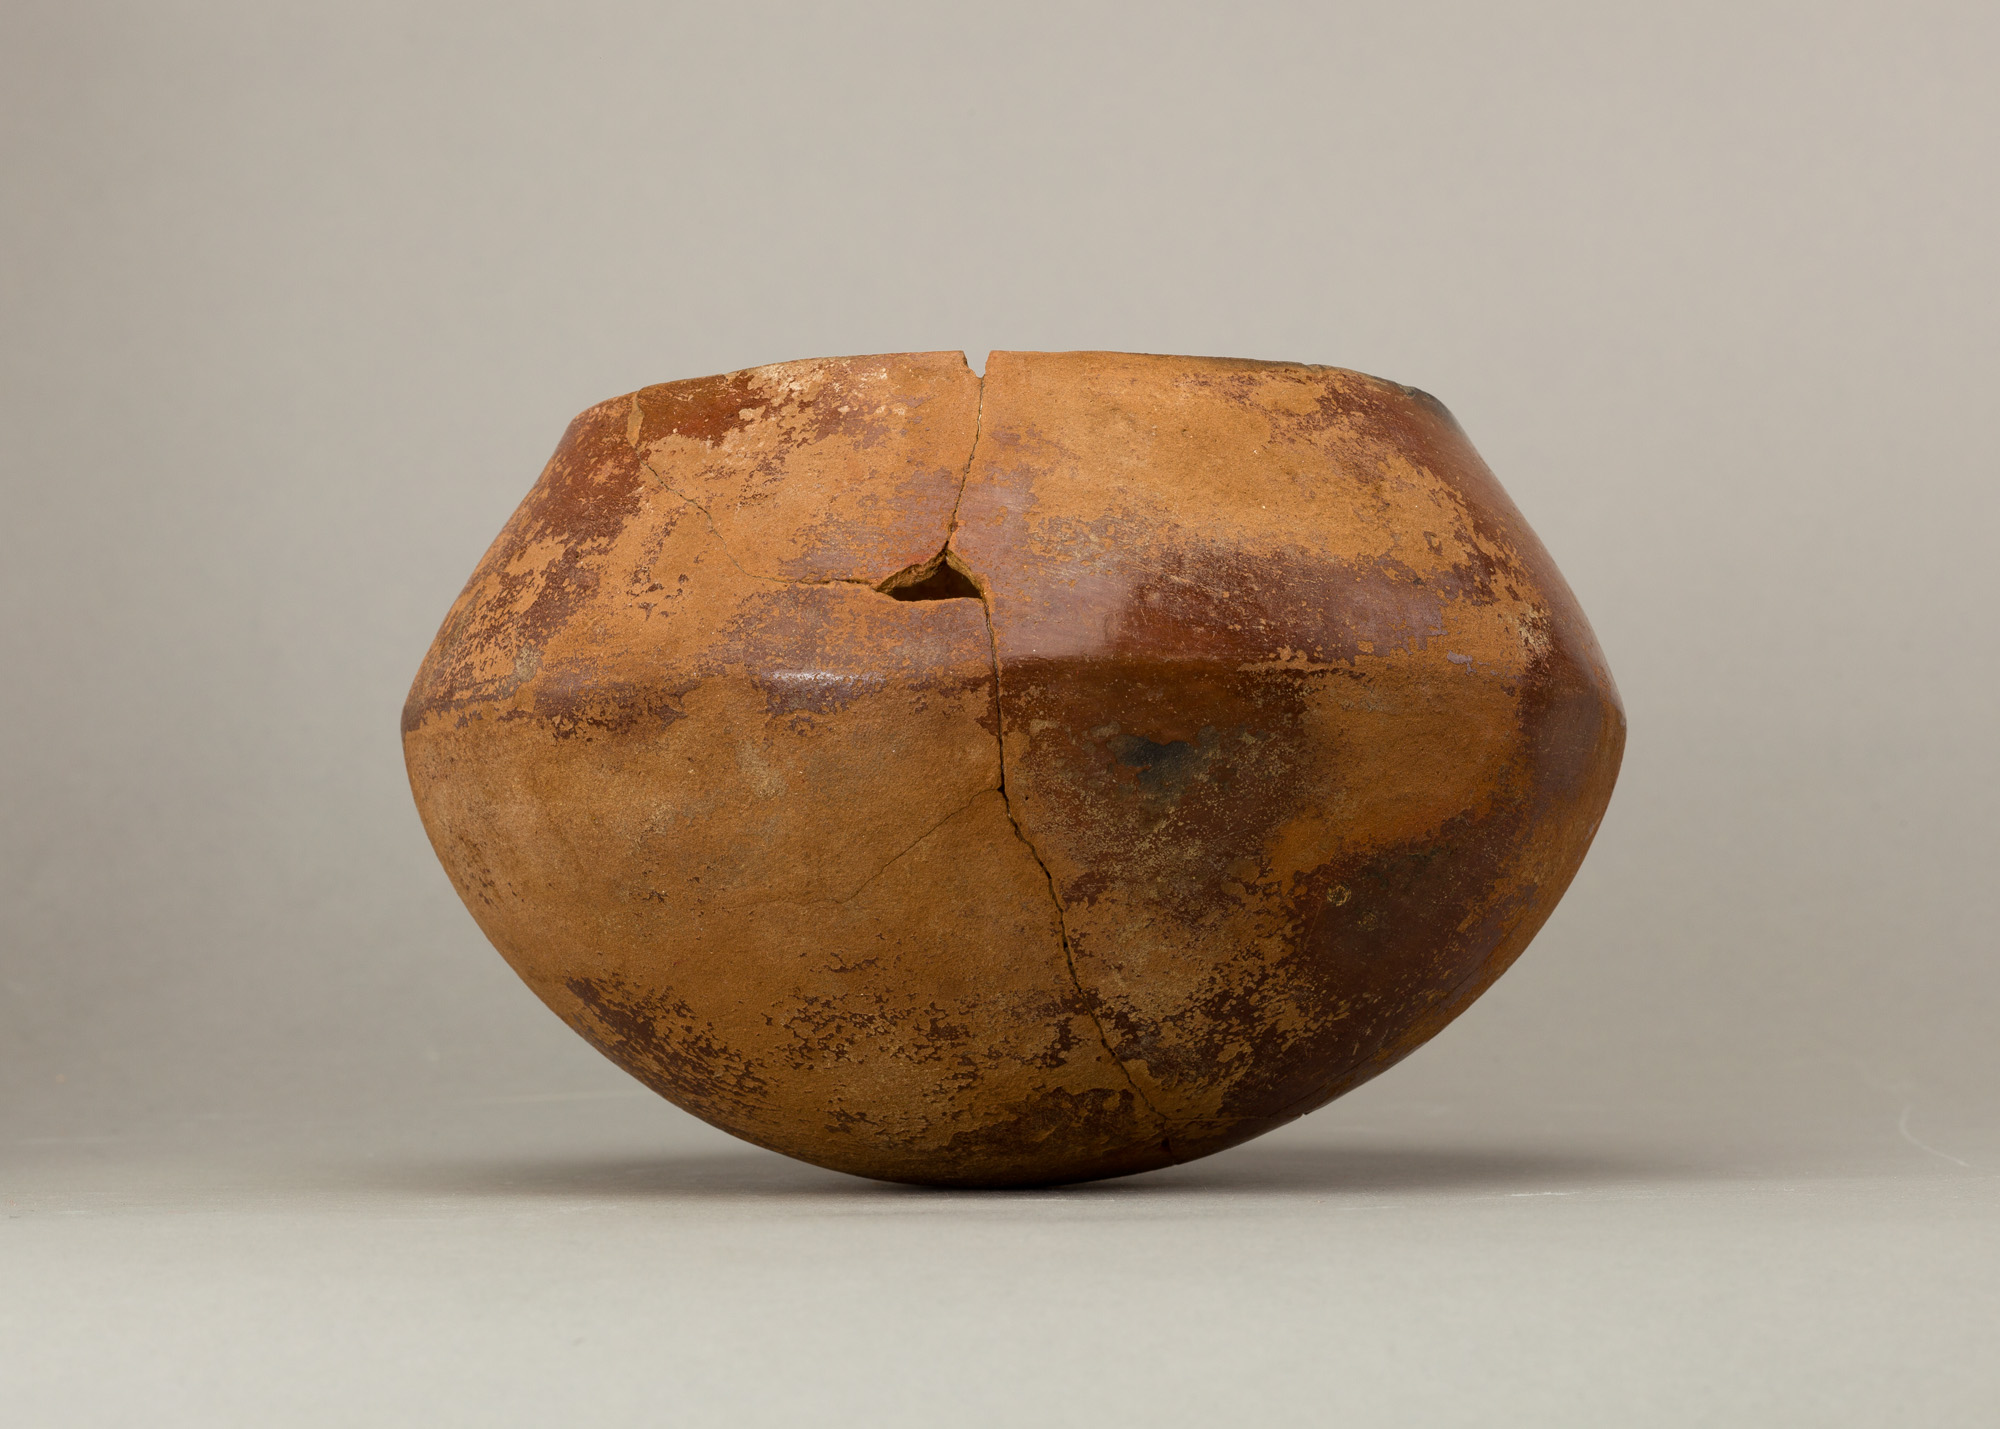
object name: bowl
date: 3850-2960 BCE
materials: pottery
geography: egypt